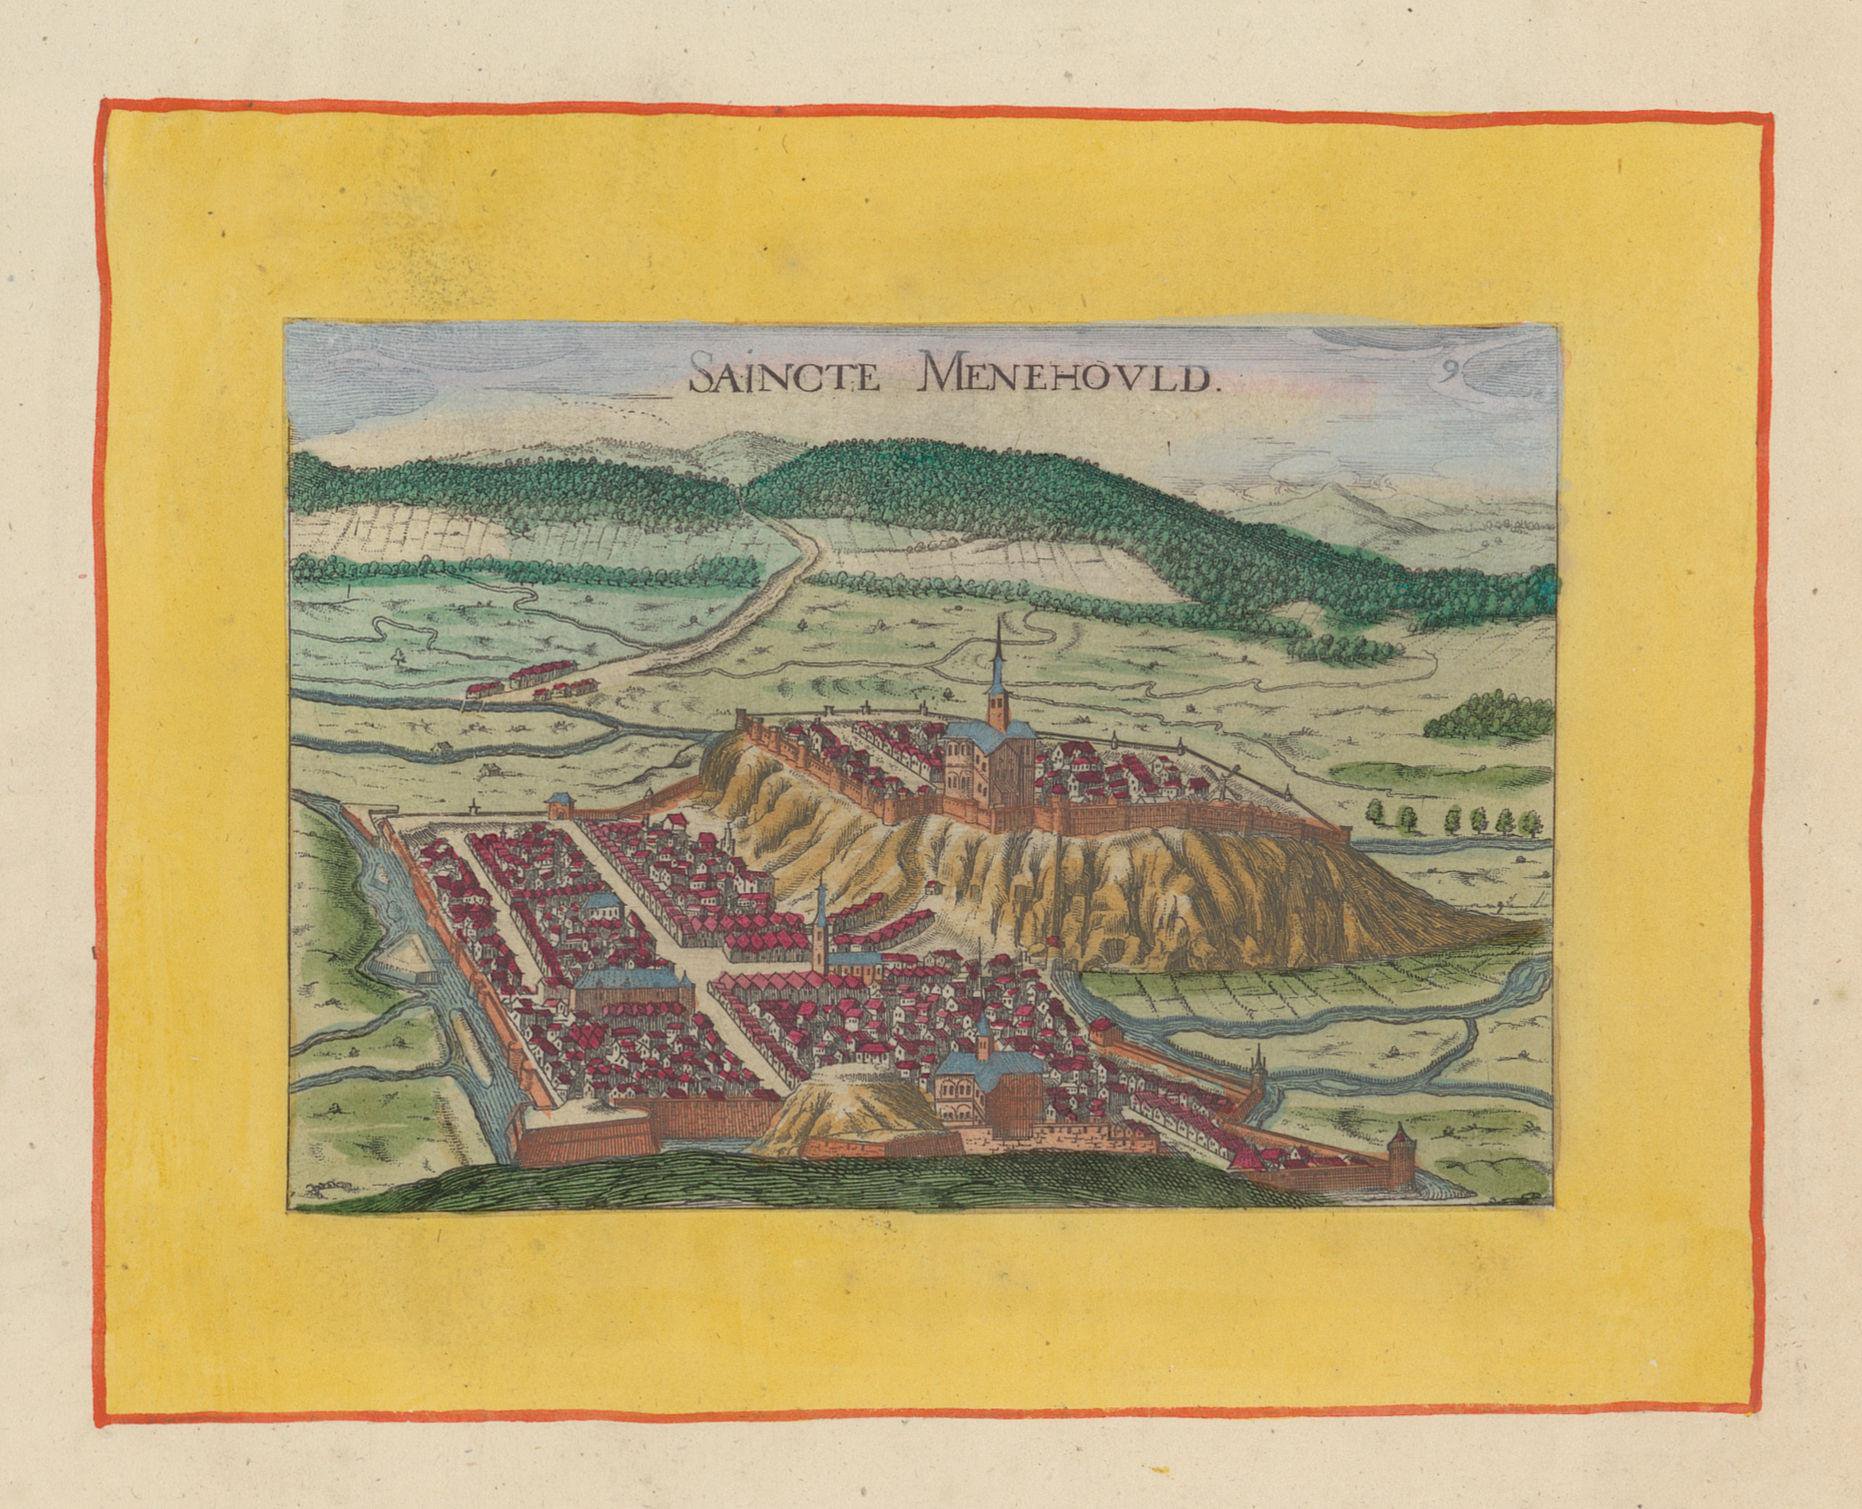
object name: album leaf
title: Gezicht op Sainte-Menehould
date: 1638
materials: paper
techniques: engraving, hand coloring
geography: paris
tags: city-view in general; 'veduta'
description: Prent uit: Tassin, Christophe. Les plans et profils de toutes les principales villes et lieux considérables de France (...). Parijs: Michel van Lochom, 1638, plattegrond 9 uit het deel 'Champagne'.